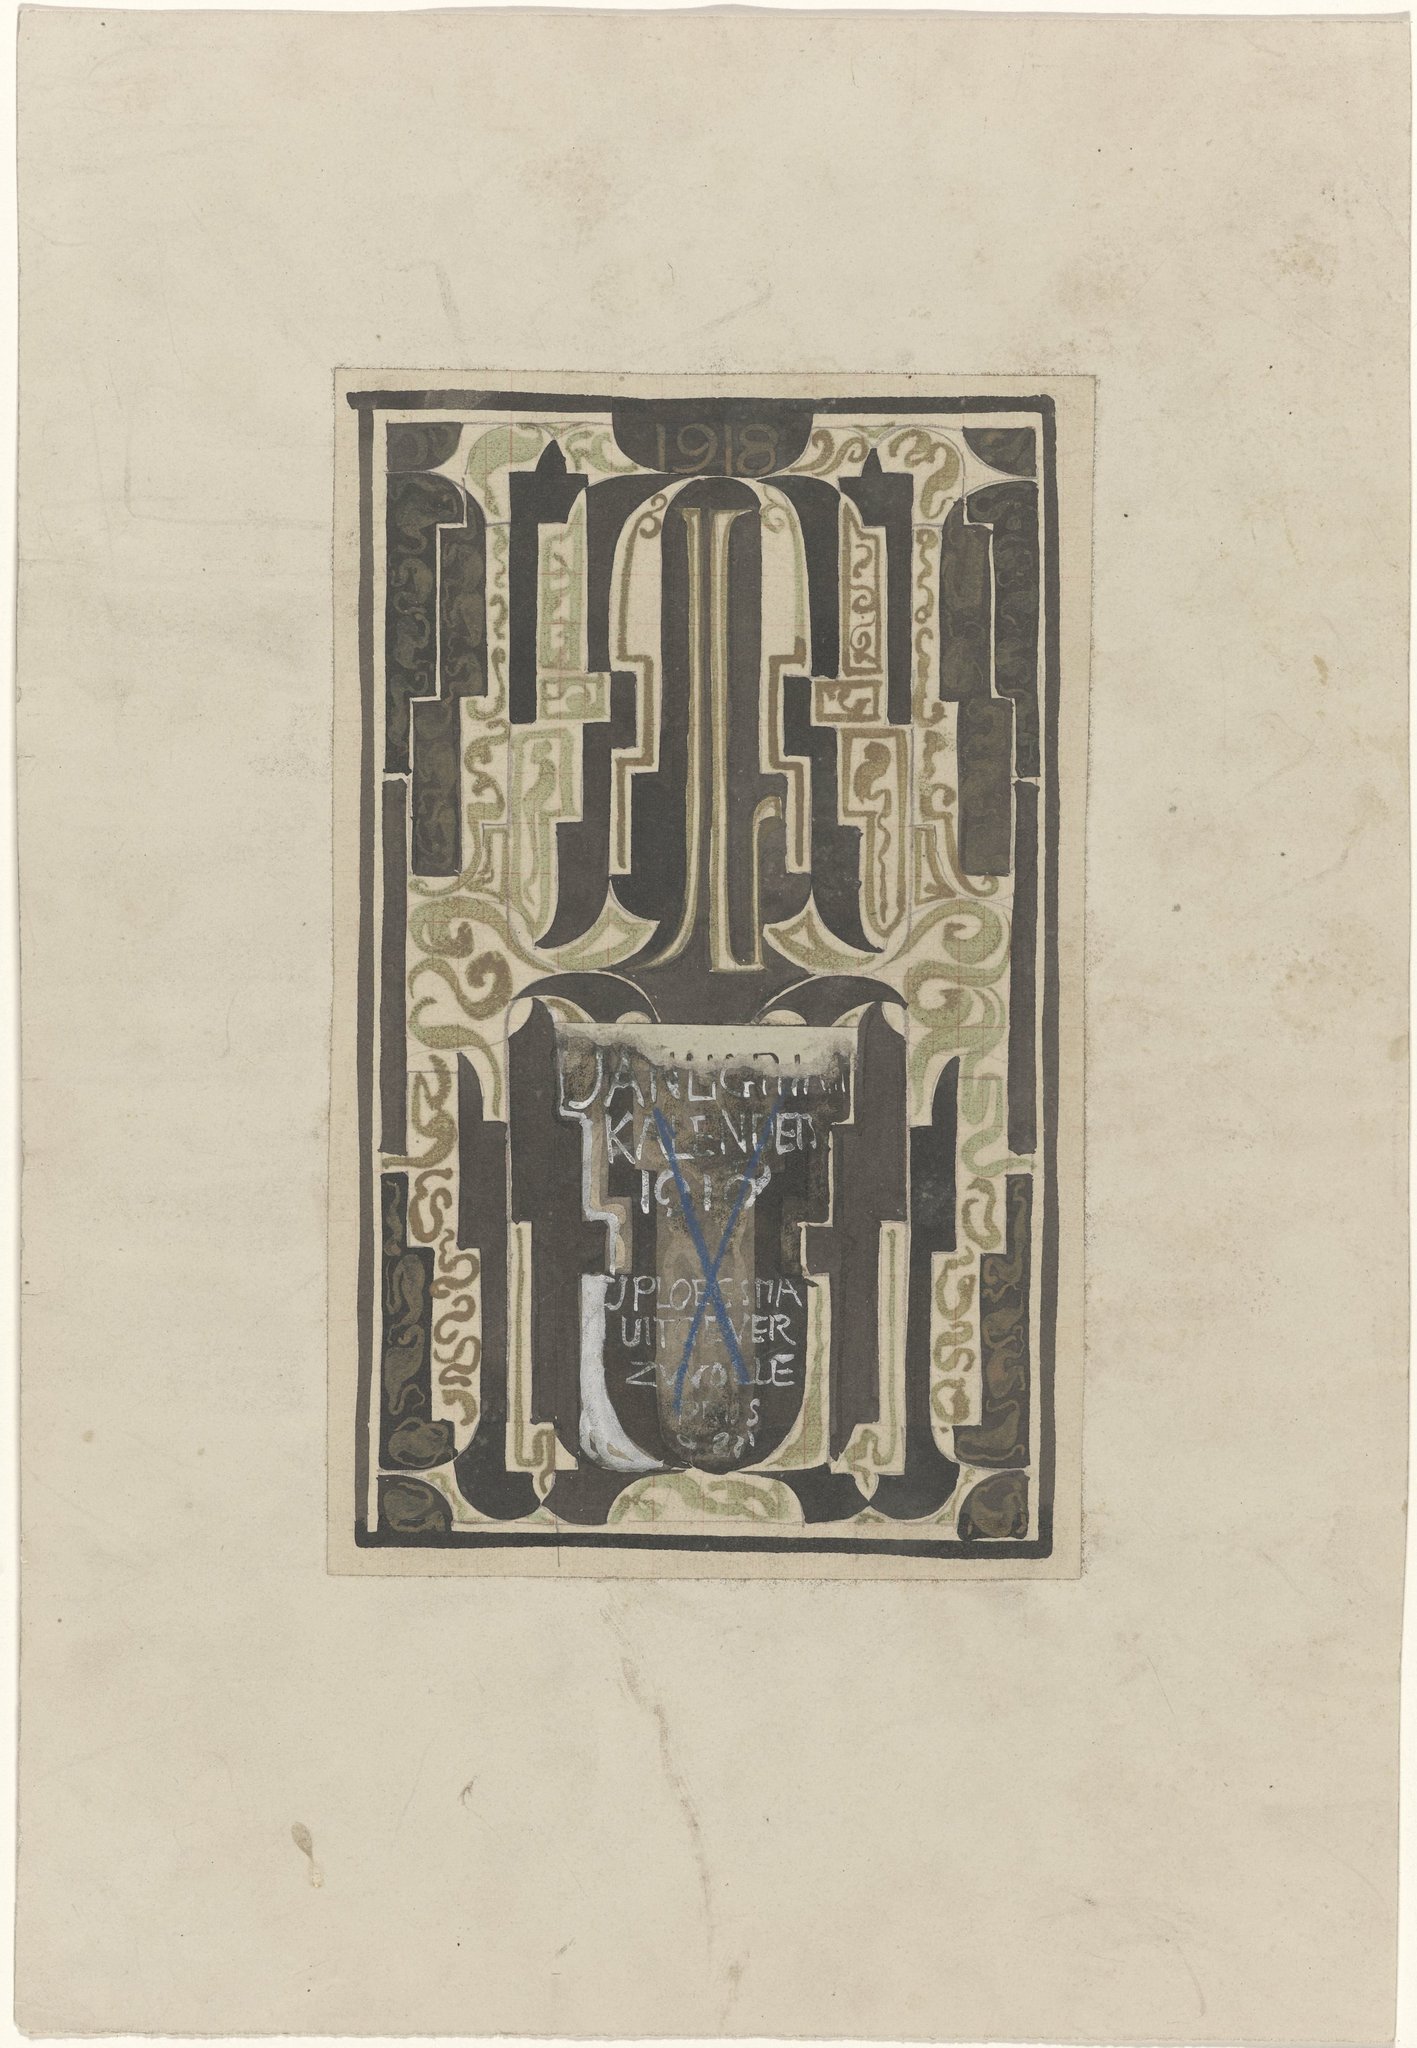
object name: drawing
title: Ontwerp voor Jan Ligthart kalender voor 1918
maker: carel adolph lion cachet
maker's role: draughtsman, print maker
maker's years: 1864-1945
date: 1874-1945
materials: paint, paper, pencil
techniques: brush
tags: calendar, almanac, historical persons